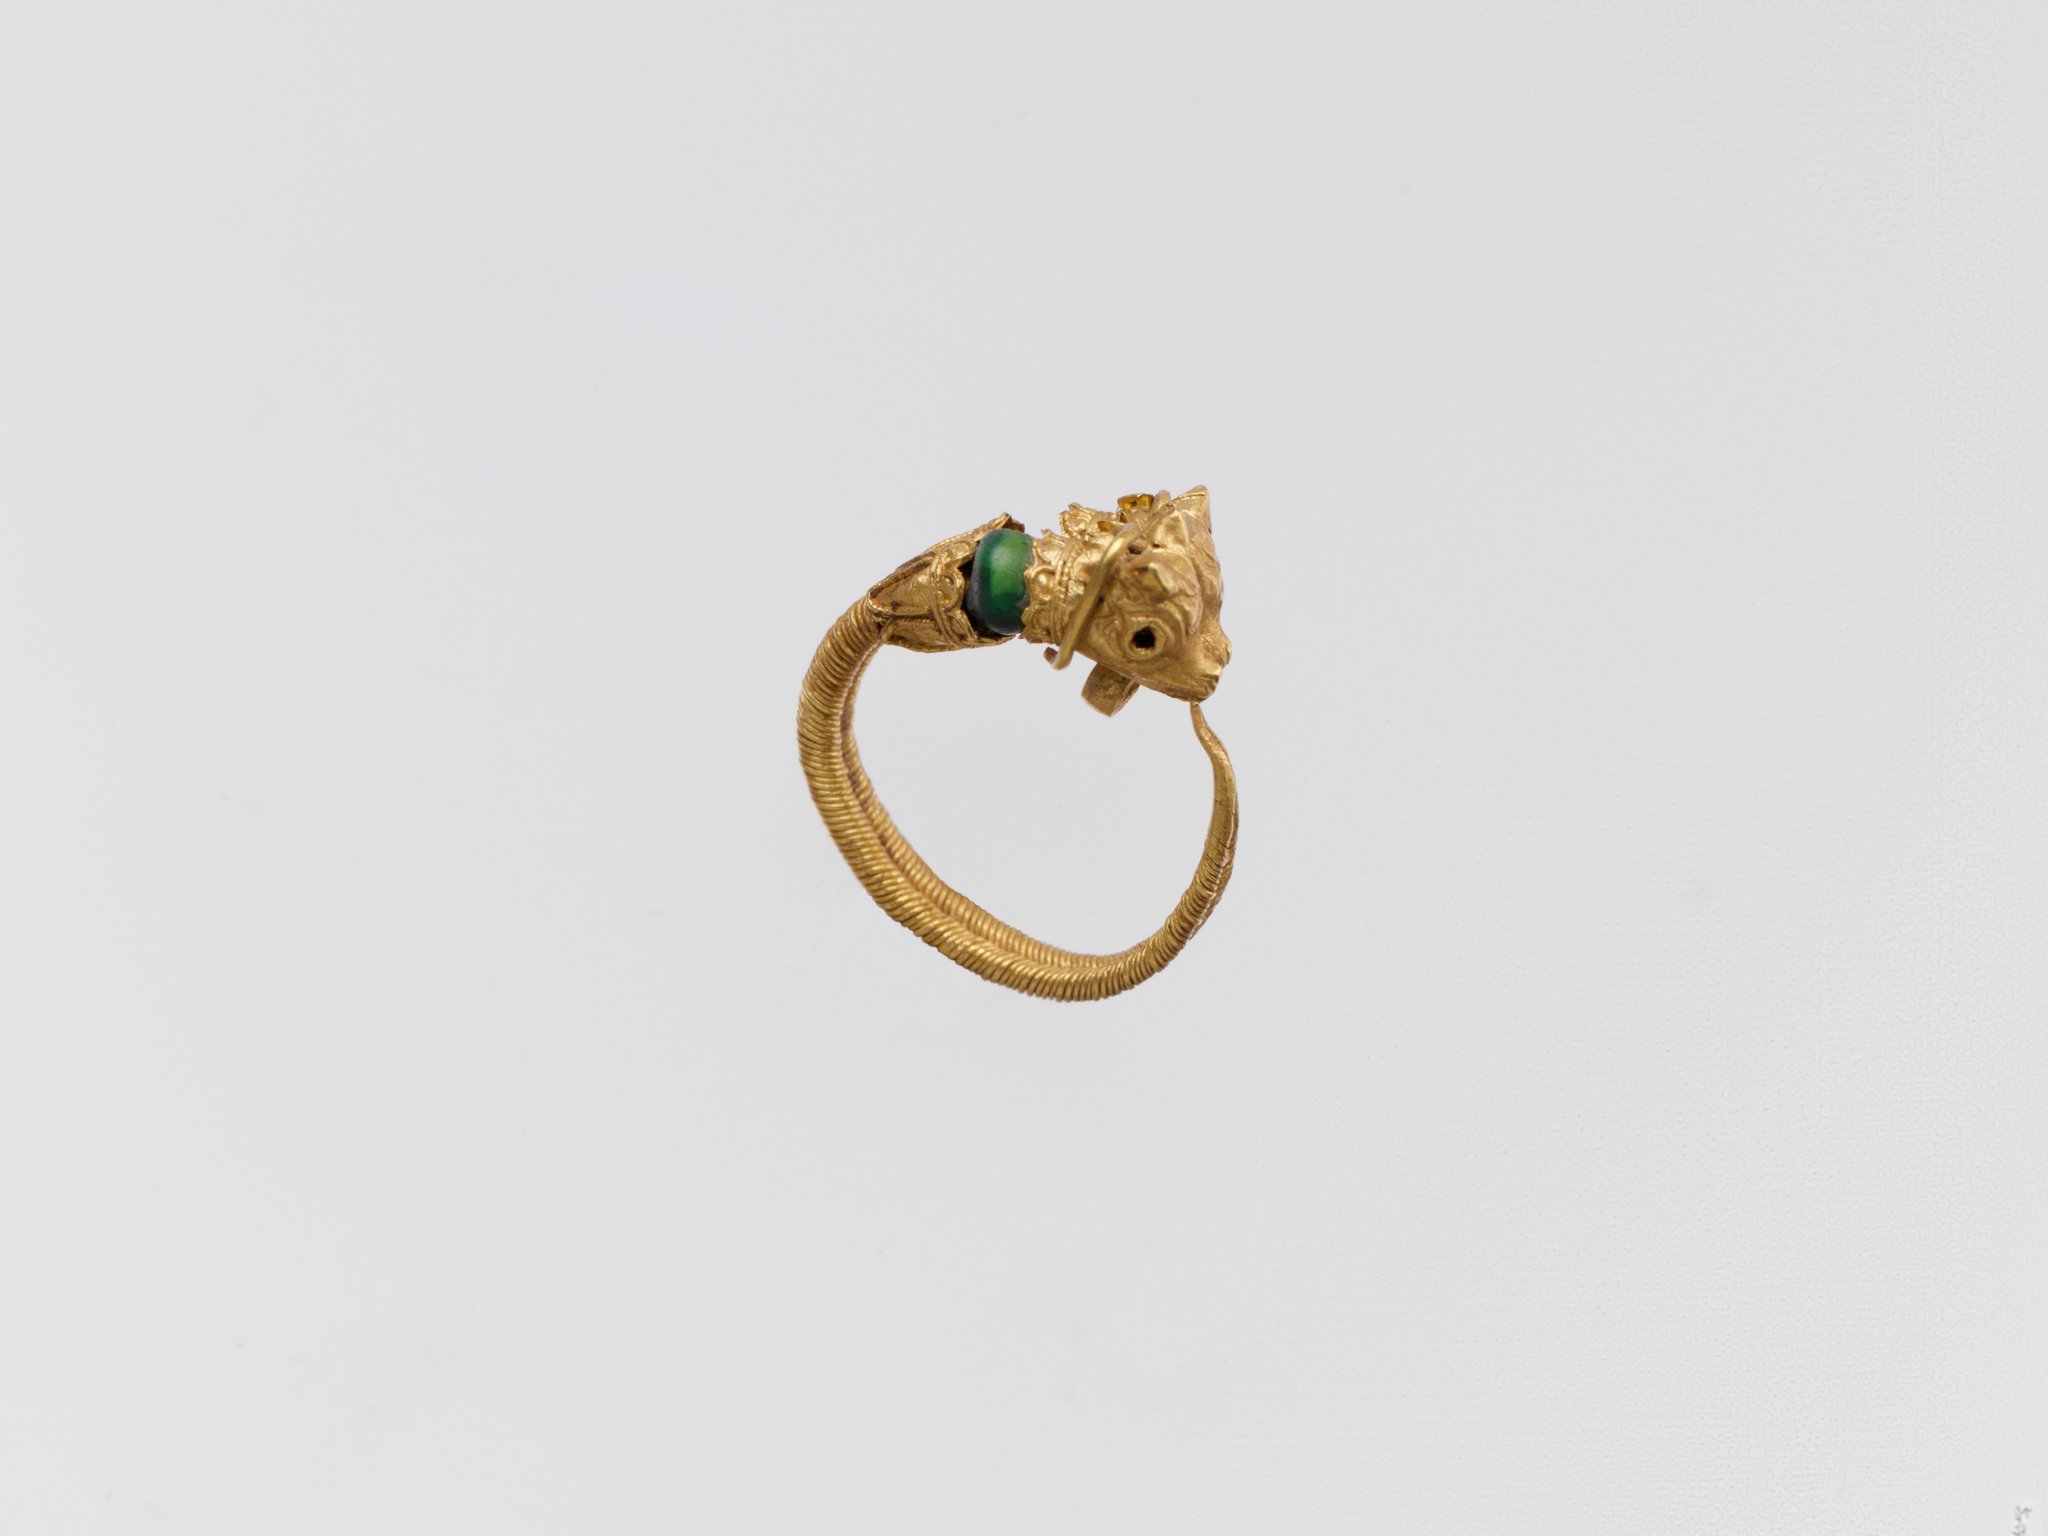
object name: earring with head of bull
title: Gold earring with two bulls' heads and glass bead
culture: greek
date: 300-101 BCE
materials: gold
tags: bulls